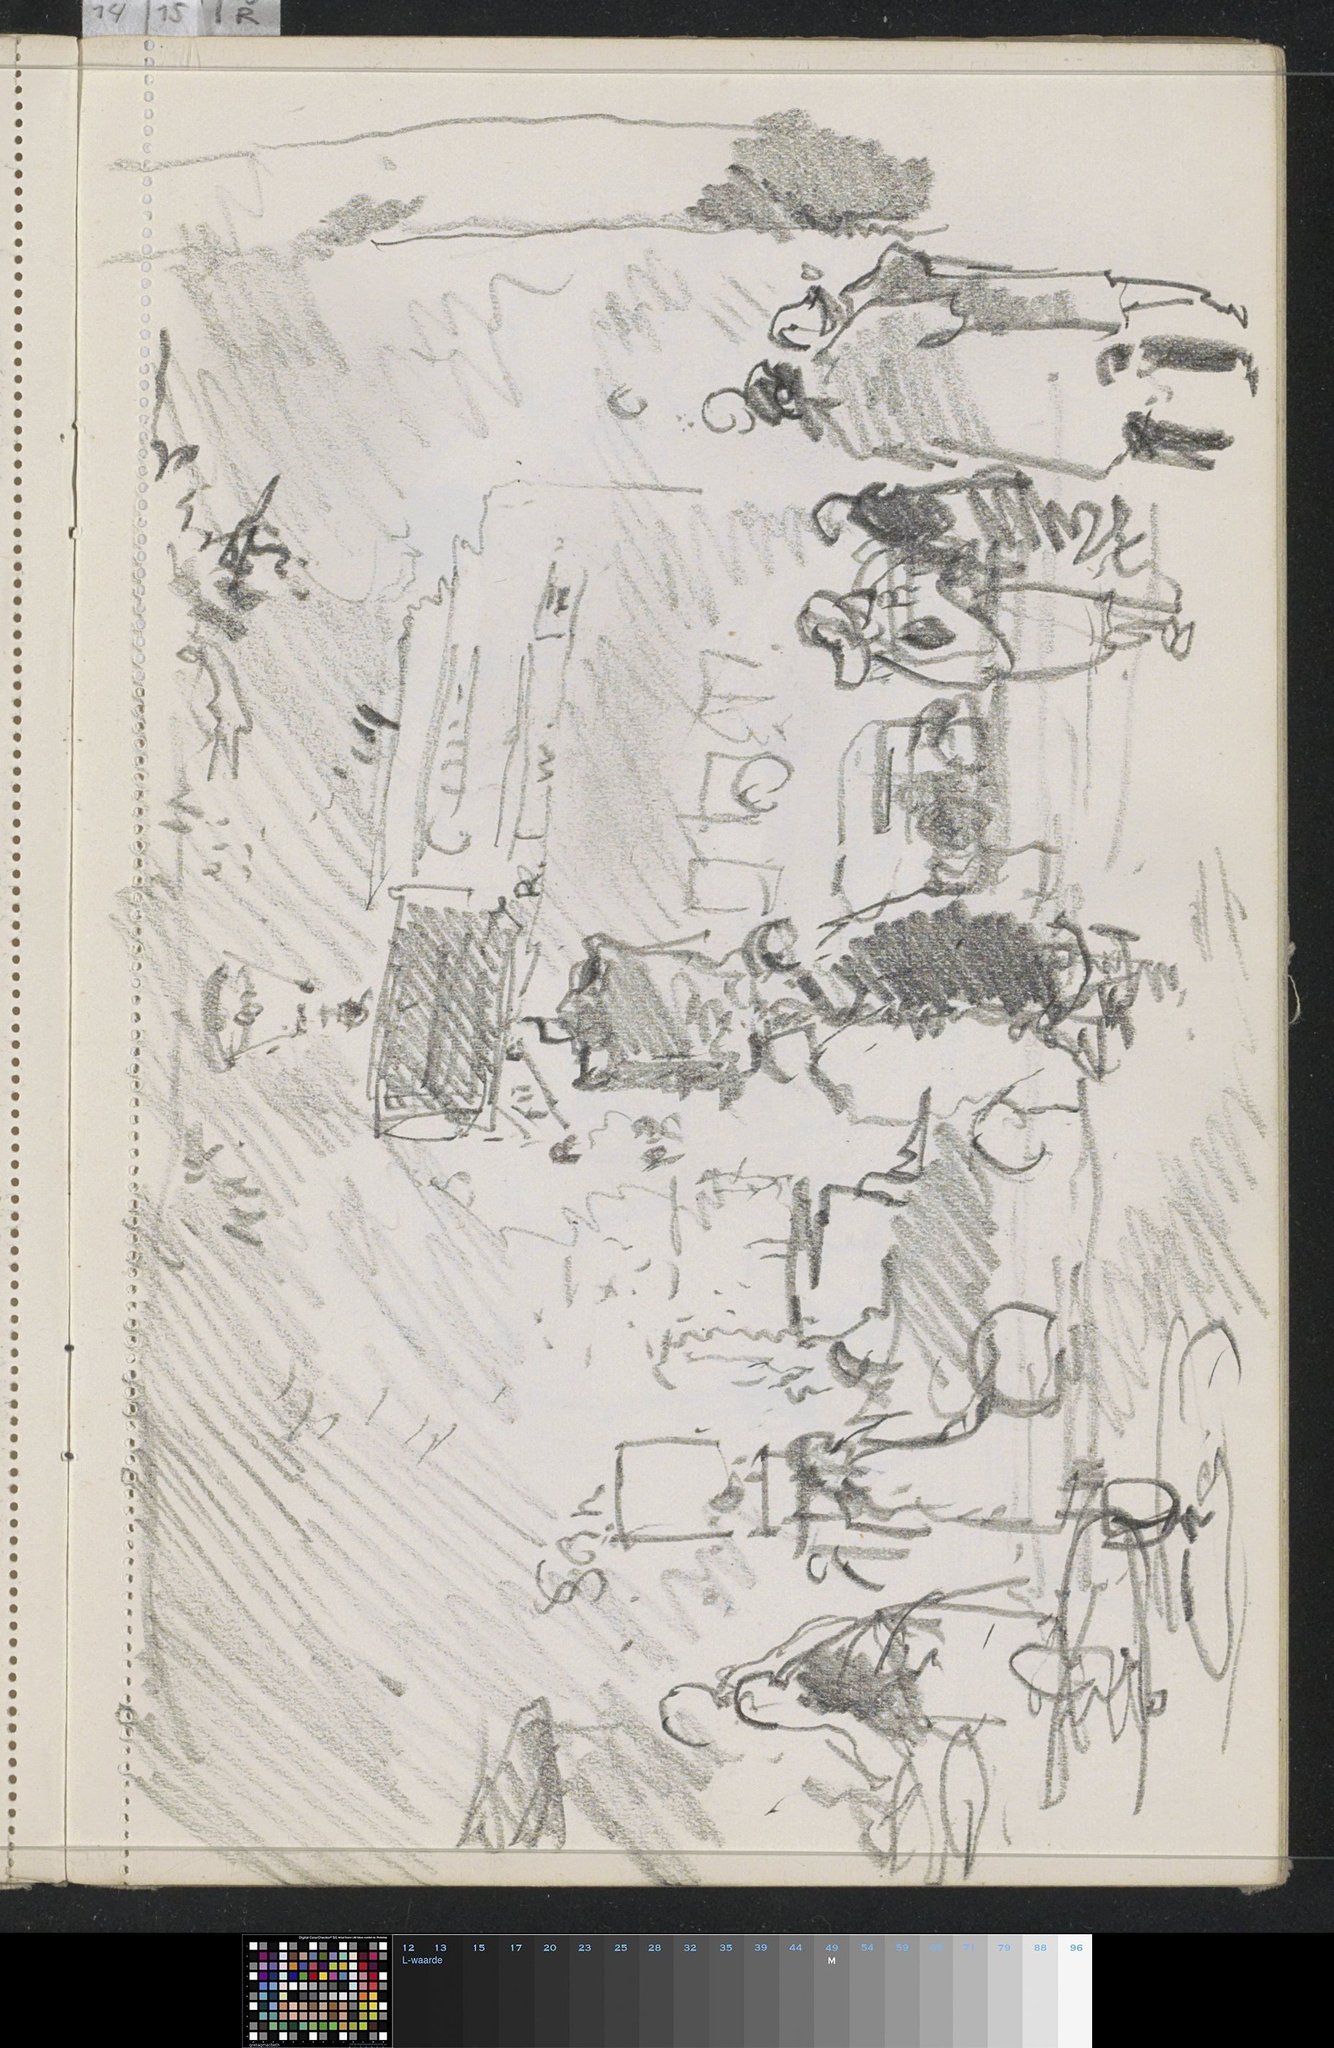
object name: sketchbook leaf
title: Figuren op een drukke straat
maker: cornelis vreedenburgh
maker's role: draughtsman, print maker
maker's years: 1880-1946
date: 1890-1946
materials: paper, pencil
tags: street (+ city(-scape) with figures, staffage)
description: Blad 14 recto uit een schetsboek met 53 bladen.